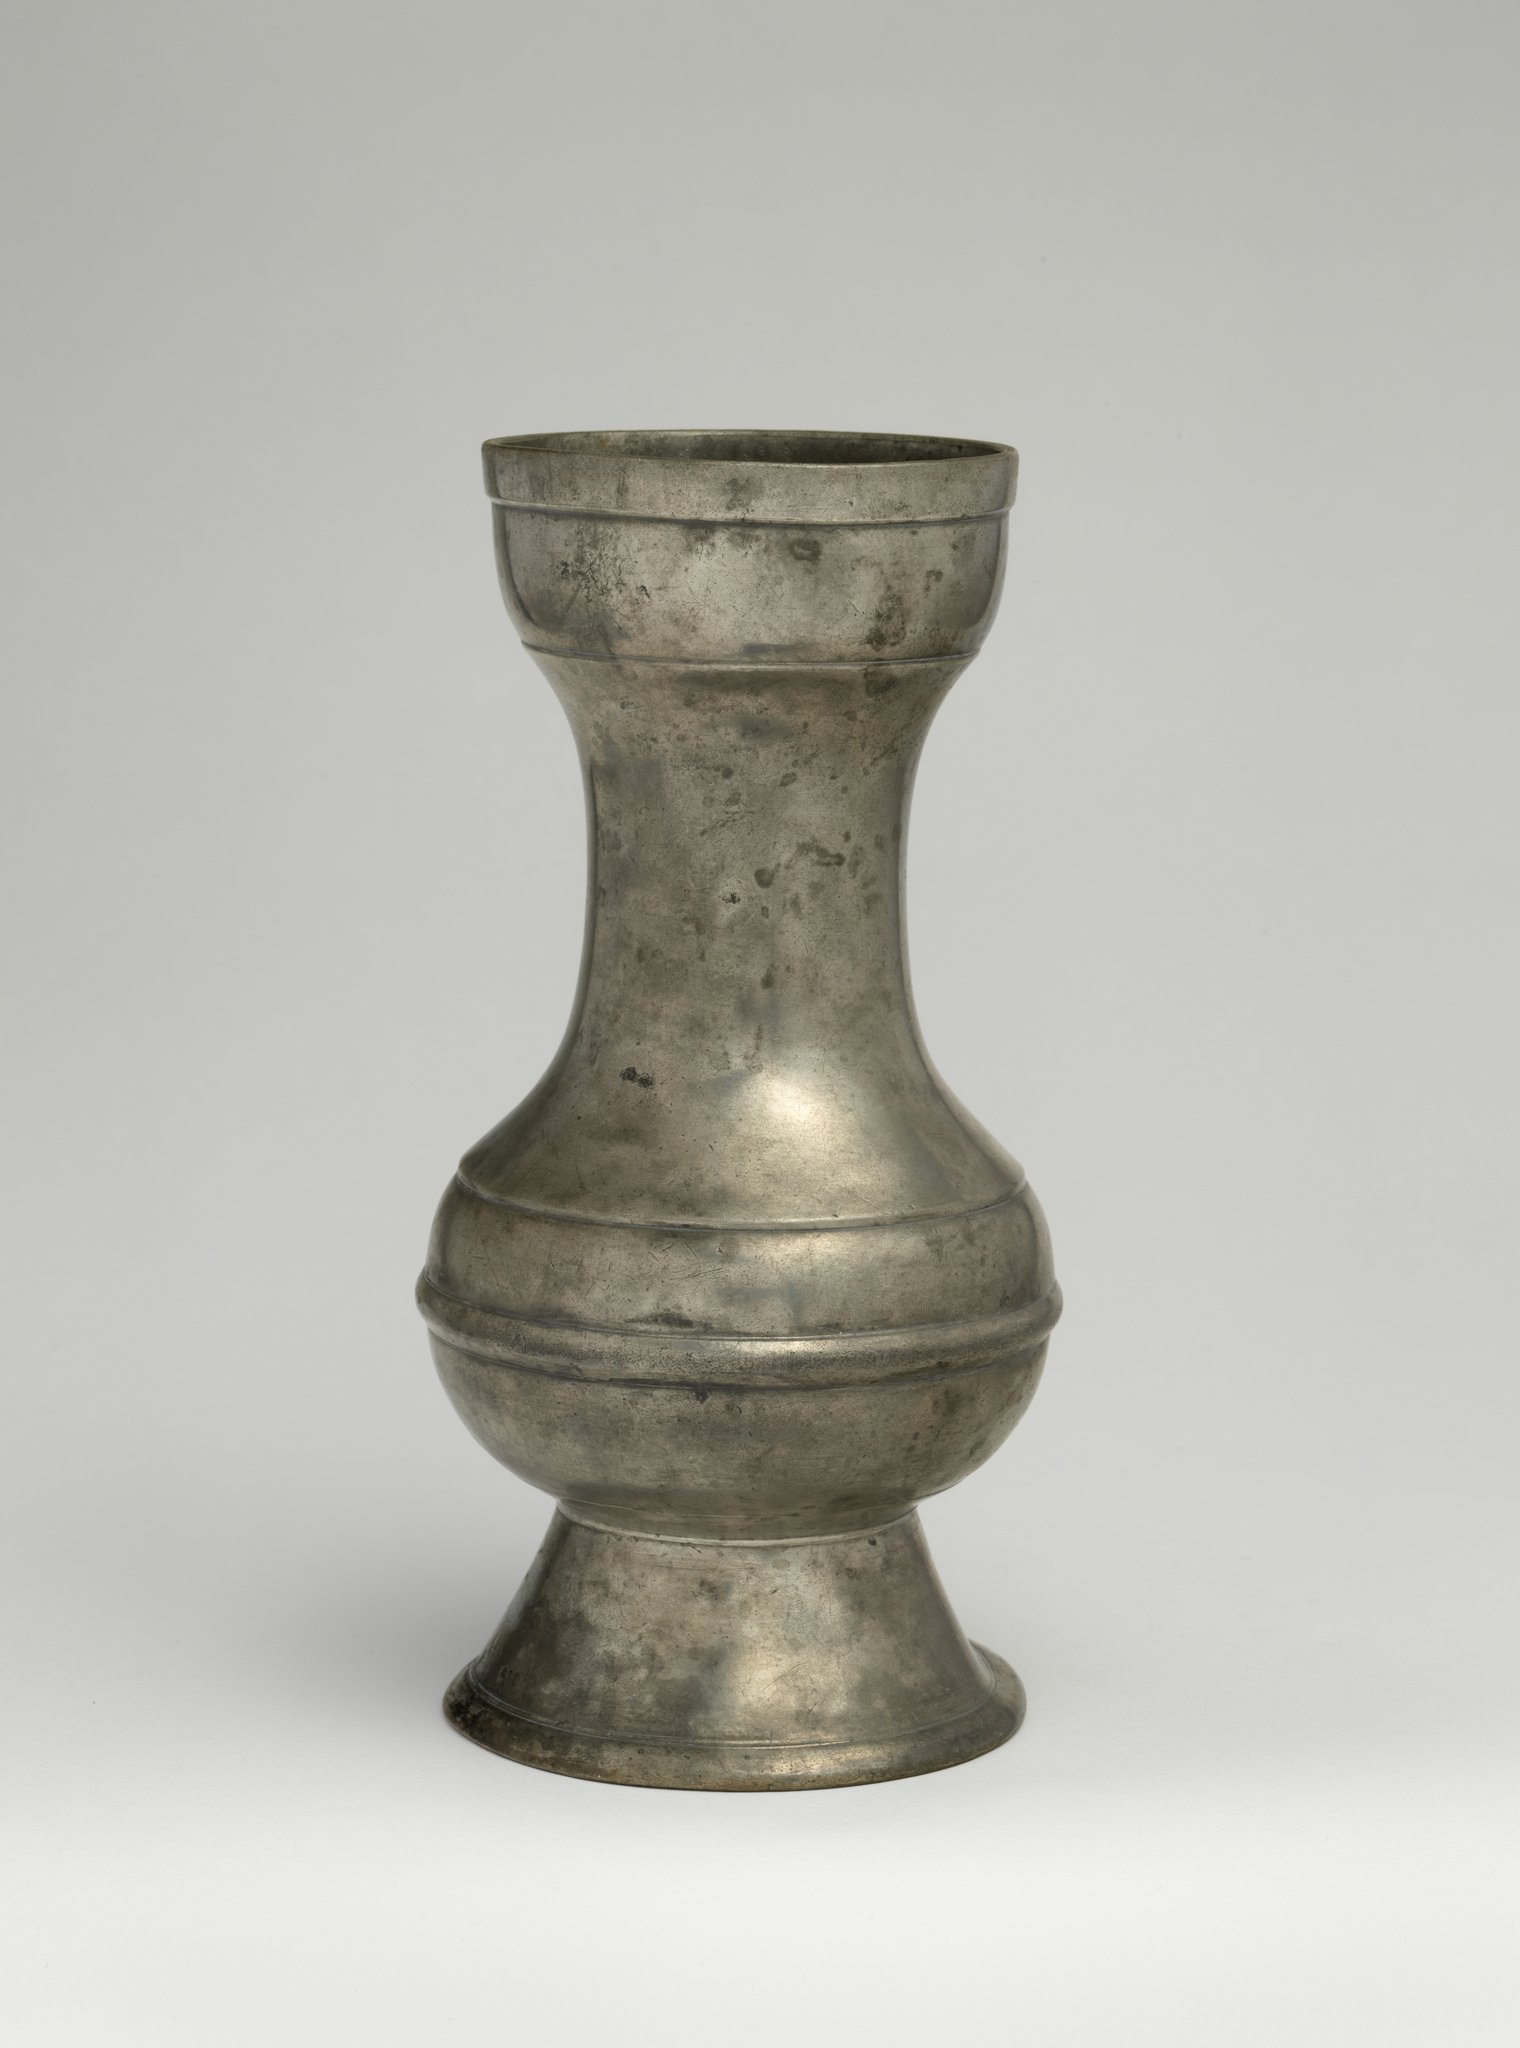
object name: measure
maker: carl adolph ferdinand heidorn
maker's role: maker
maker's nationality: german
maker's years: 1823-1893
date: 1854-1893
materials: pewter